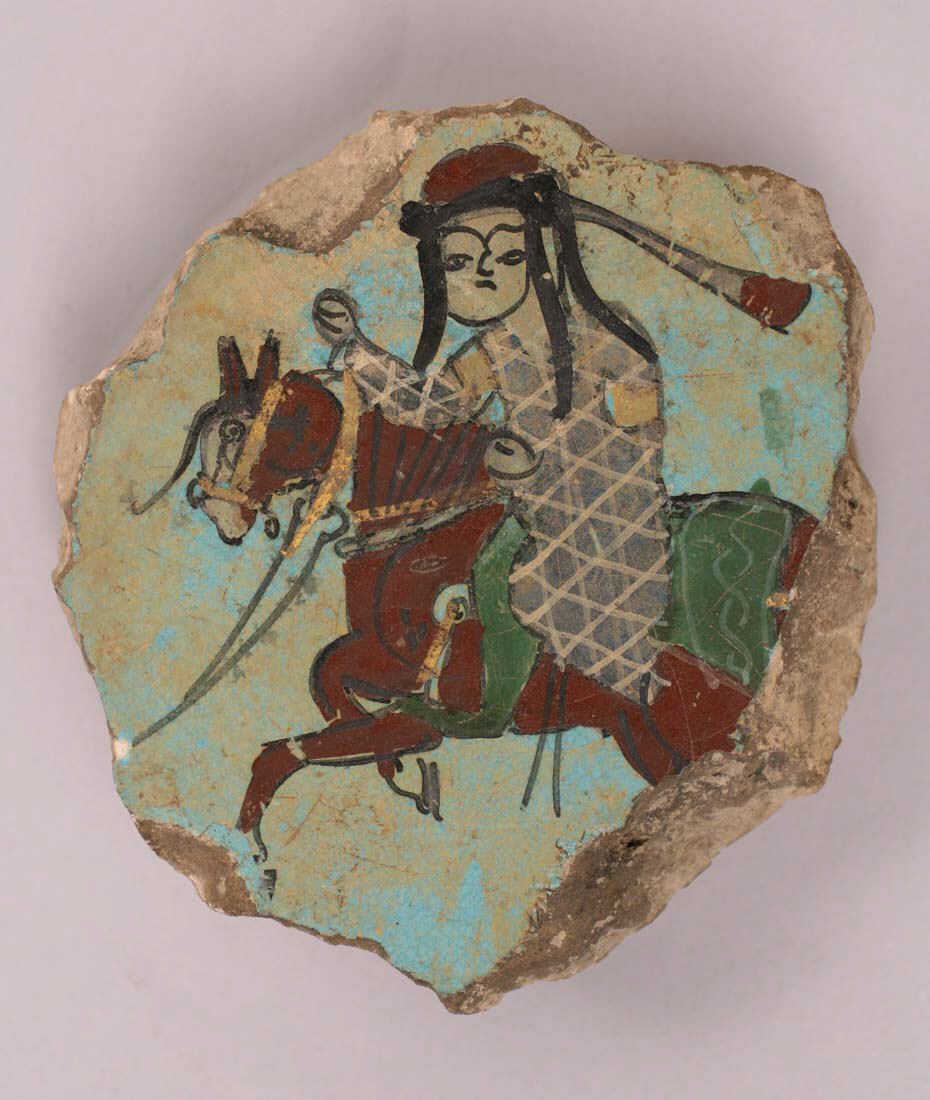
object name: fragment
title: Fragment of a Bowl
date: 1101-1300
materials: stonepaste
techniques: overglaze, painting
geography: iran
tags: men,horses